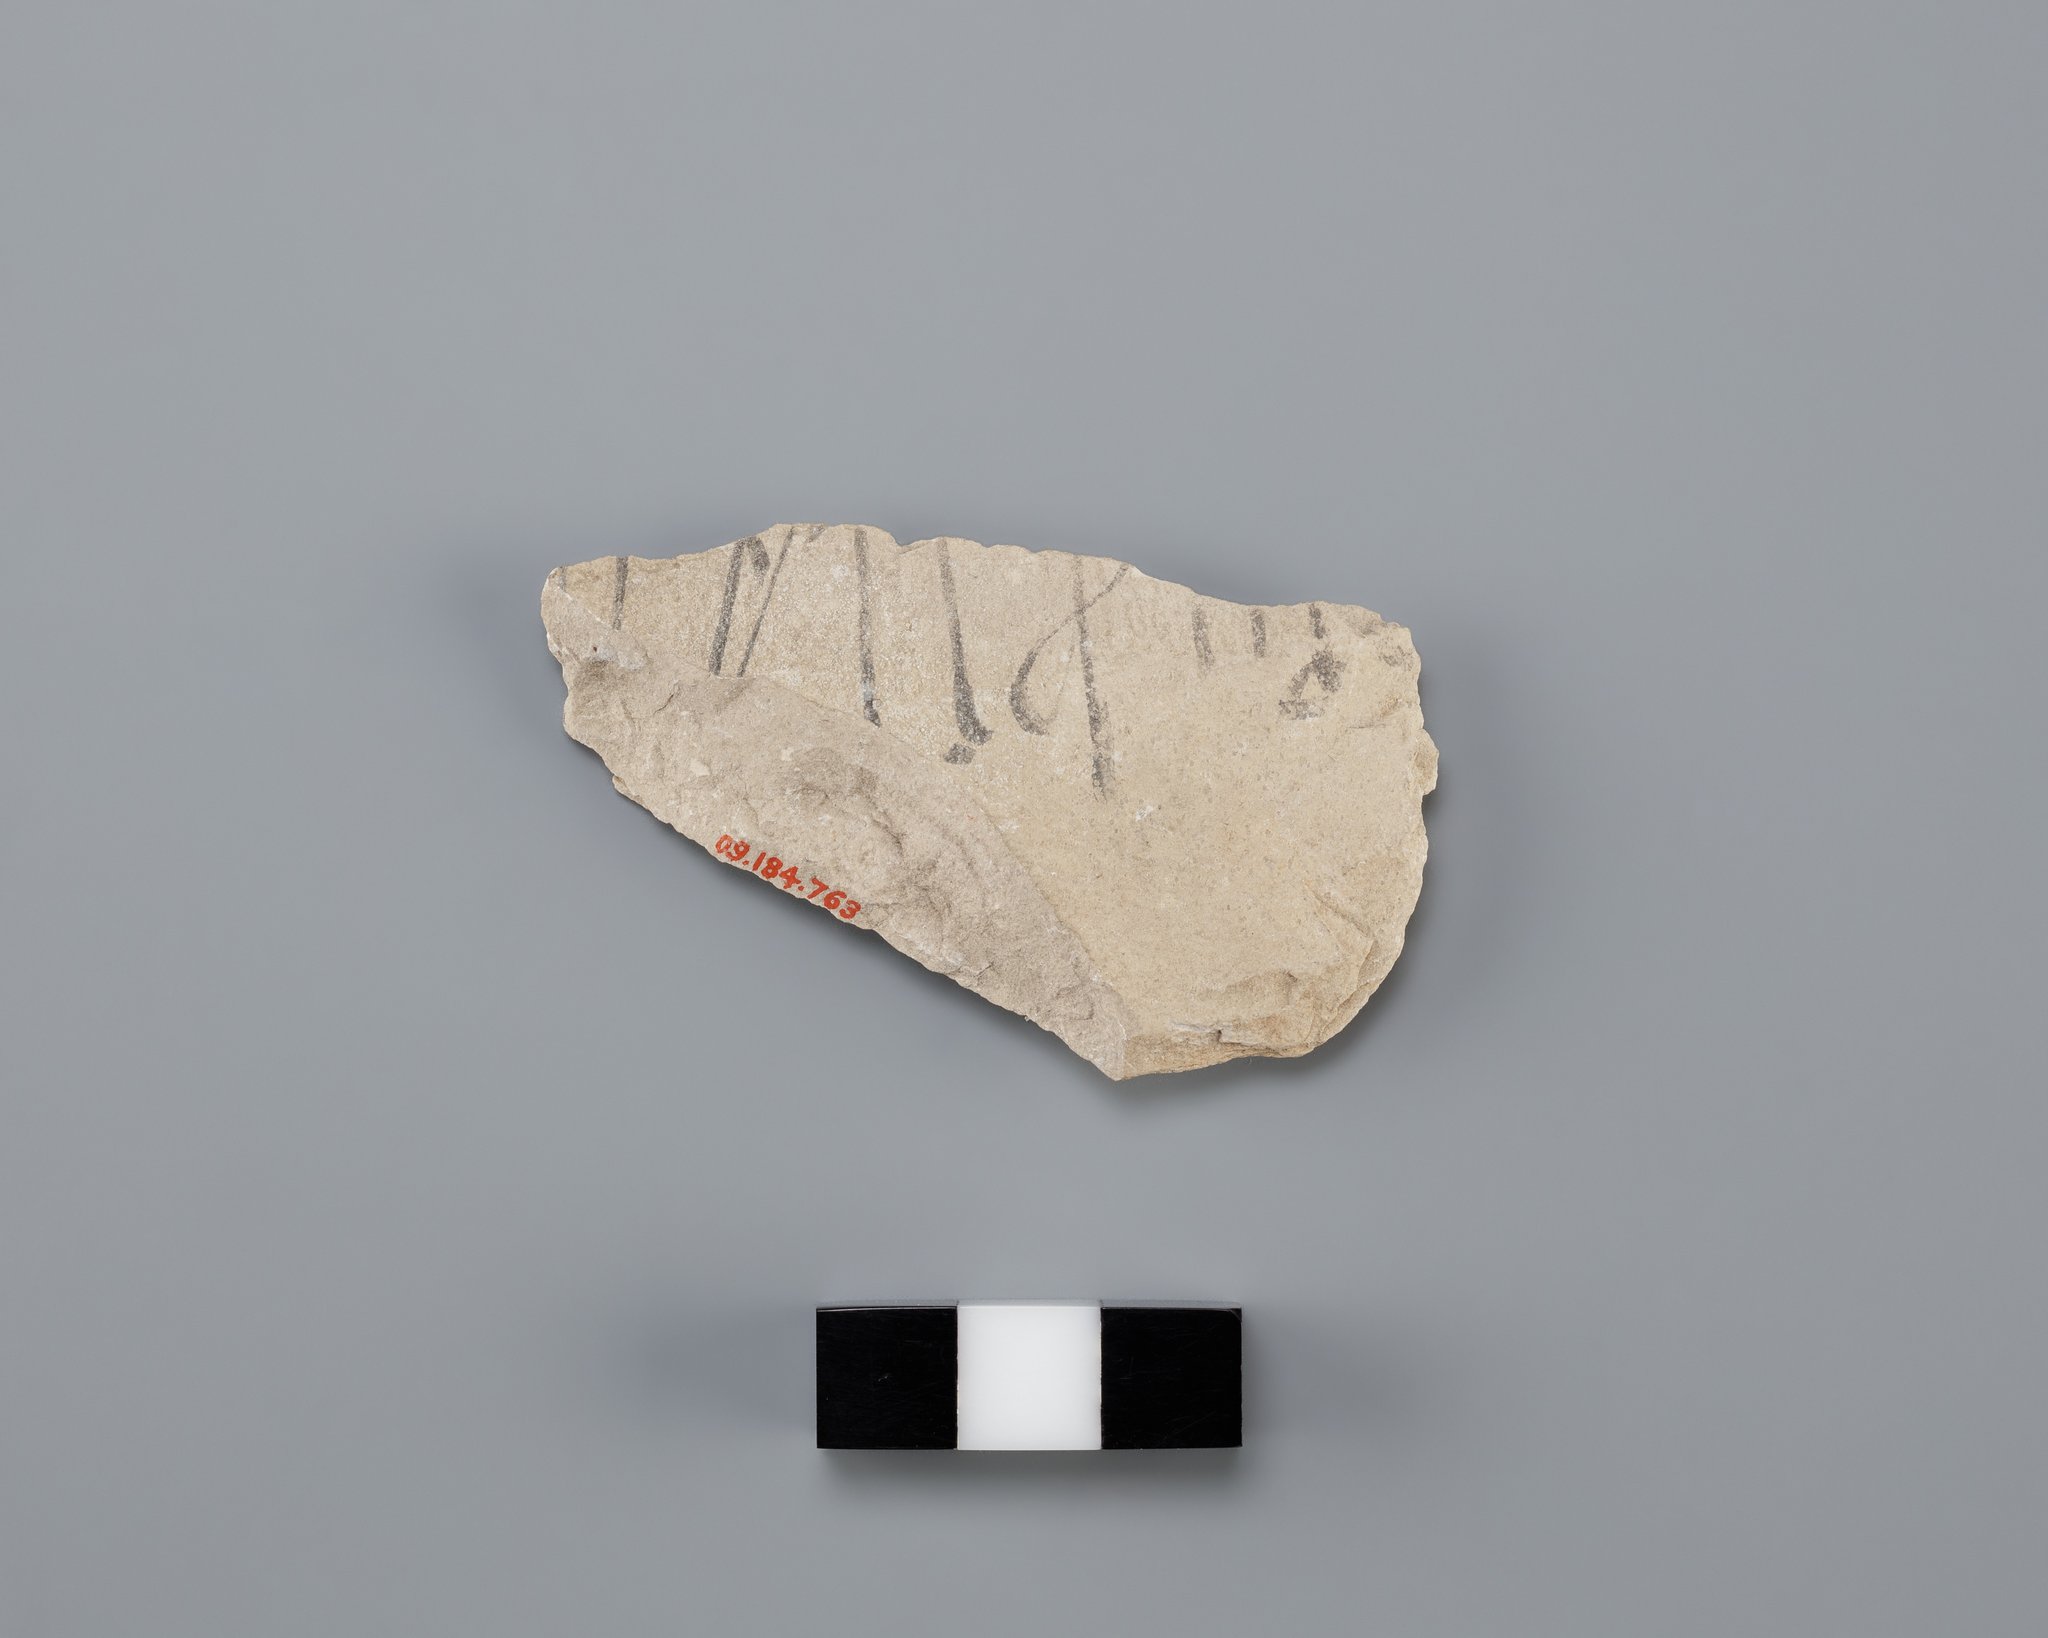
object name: ostracon, hieratic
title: Hieratic ostracon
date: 1295-1070 BCE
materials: ink, limestone, paint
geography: egypt